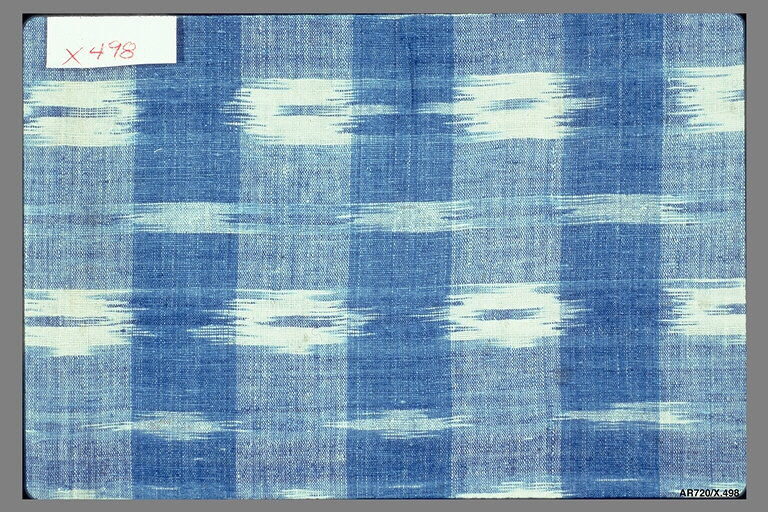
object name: piece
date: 1701-1800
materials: cotton